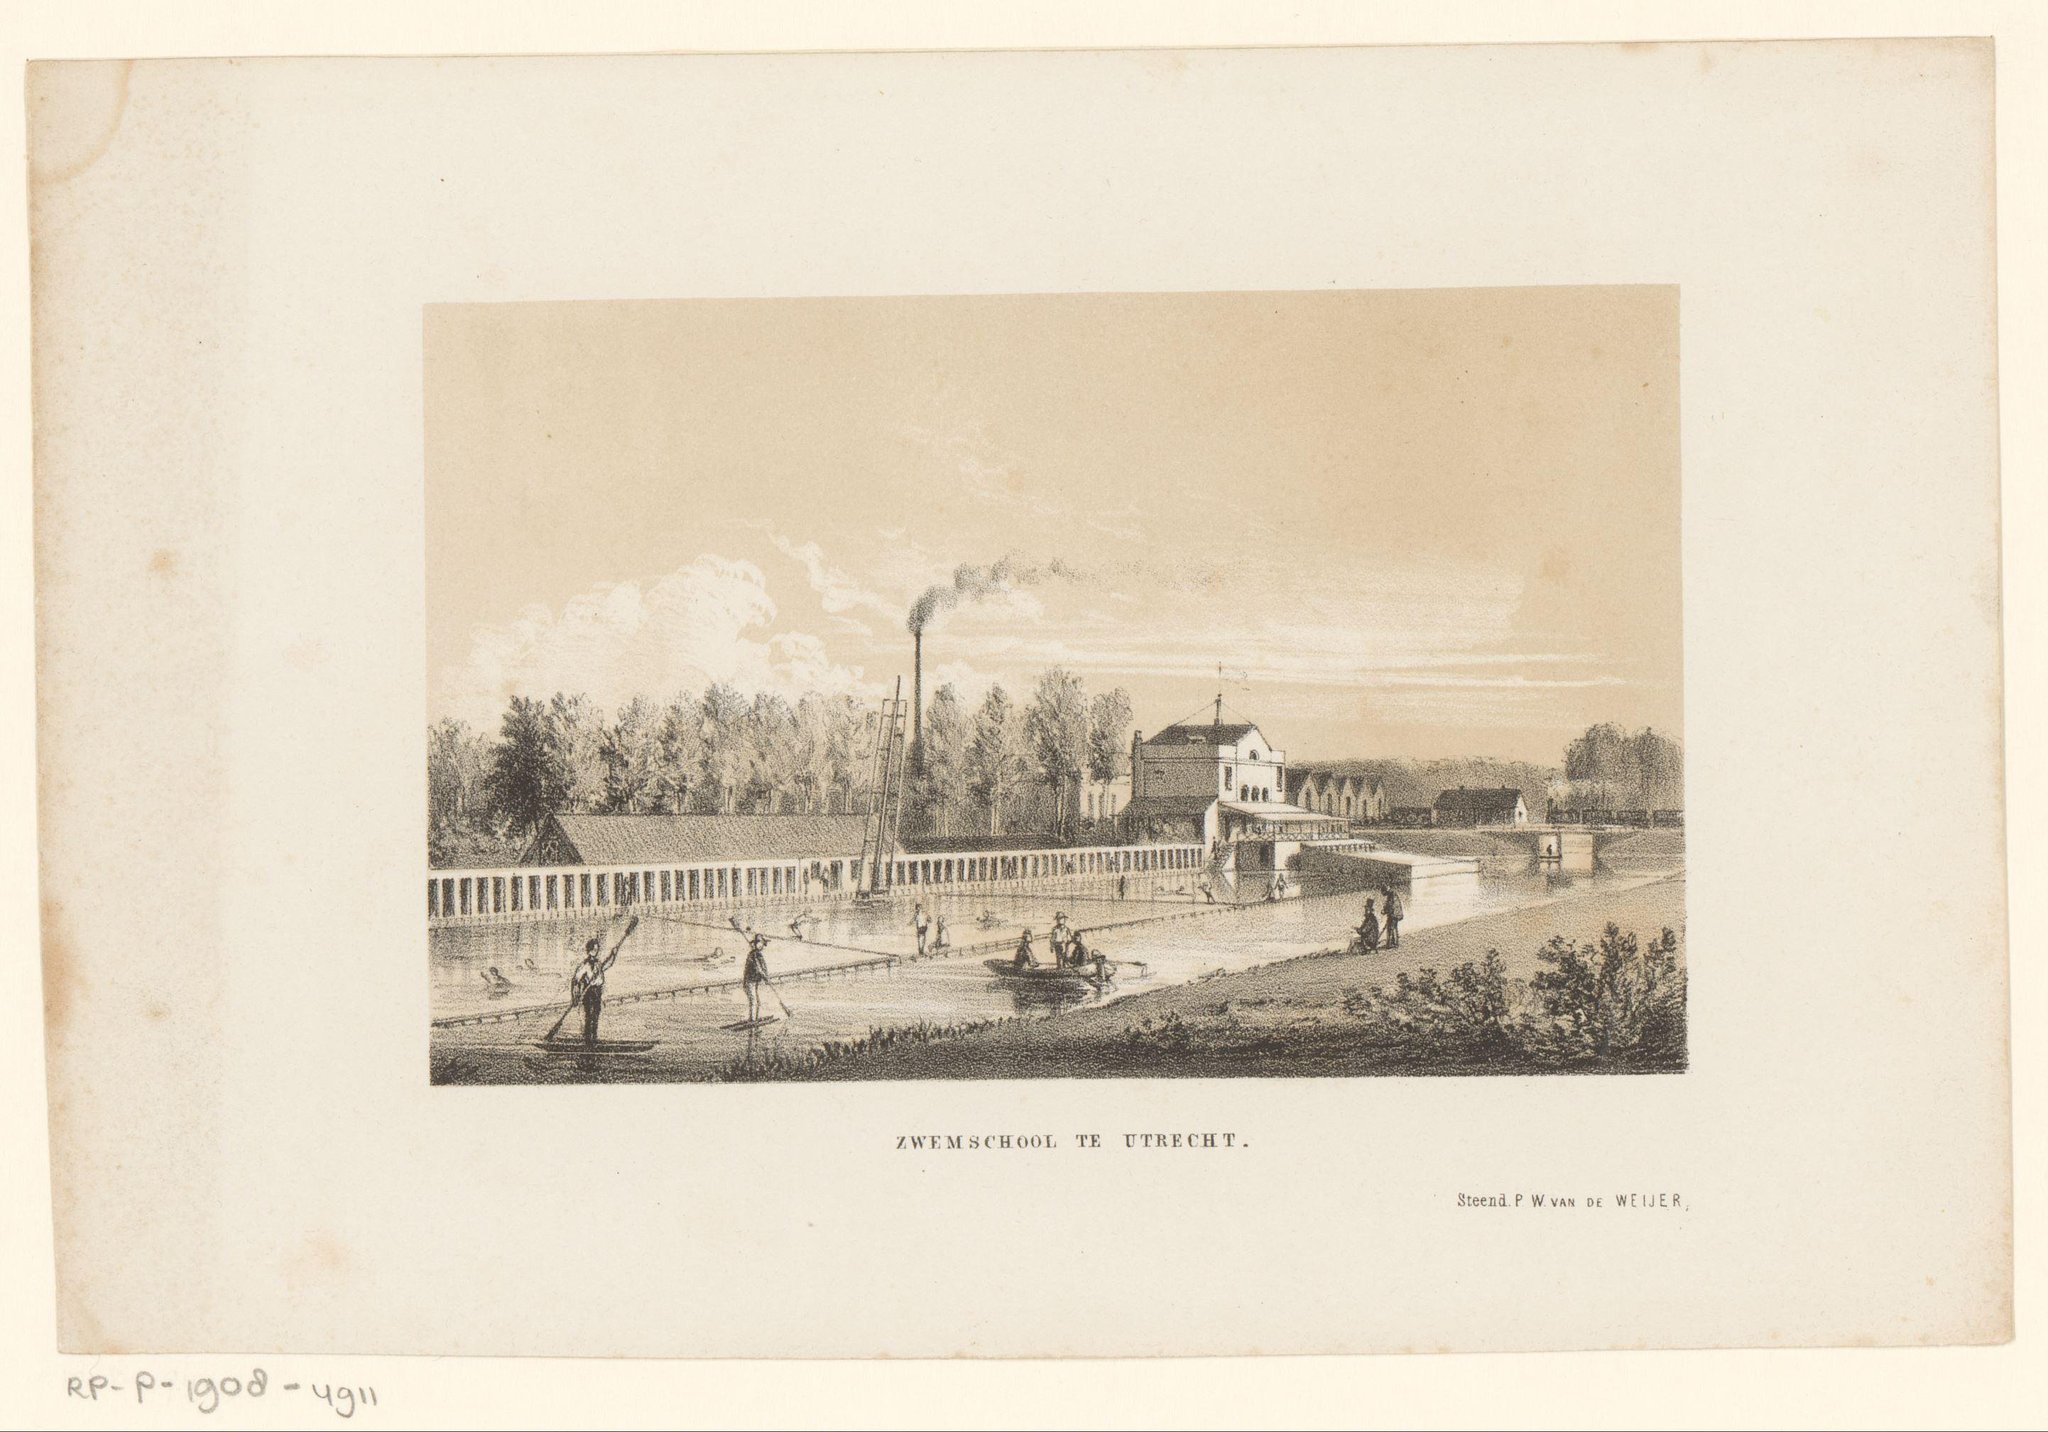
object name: print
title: Zwemschool te Utrecht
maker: pieter wilhelmus van de weijer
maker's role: print maker, printer, publisher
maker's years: 1816-1880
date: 1856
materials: paper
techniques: tone lithography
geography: utrecht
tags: swimming (sport), public baths - aa - in the open air, utrecht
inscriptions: collector's mark: Lugt 2228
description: Mogelijk maakte deze prent deel uit van: Utrecht's Album, Utrecht: W.F.Dannenfelser, 1856.